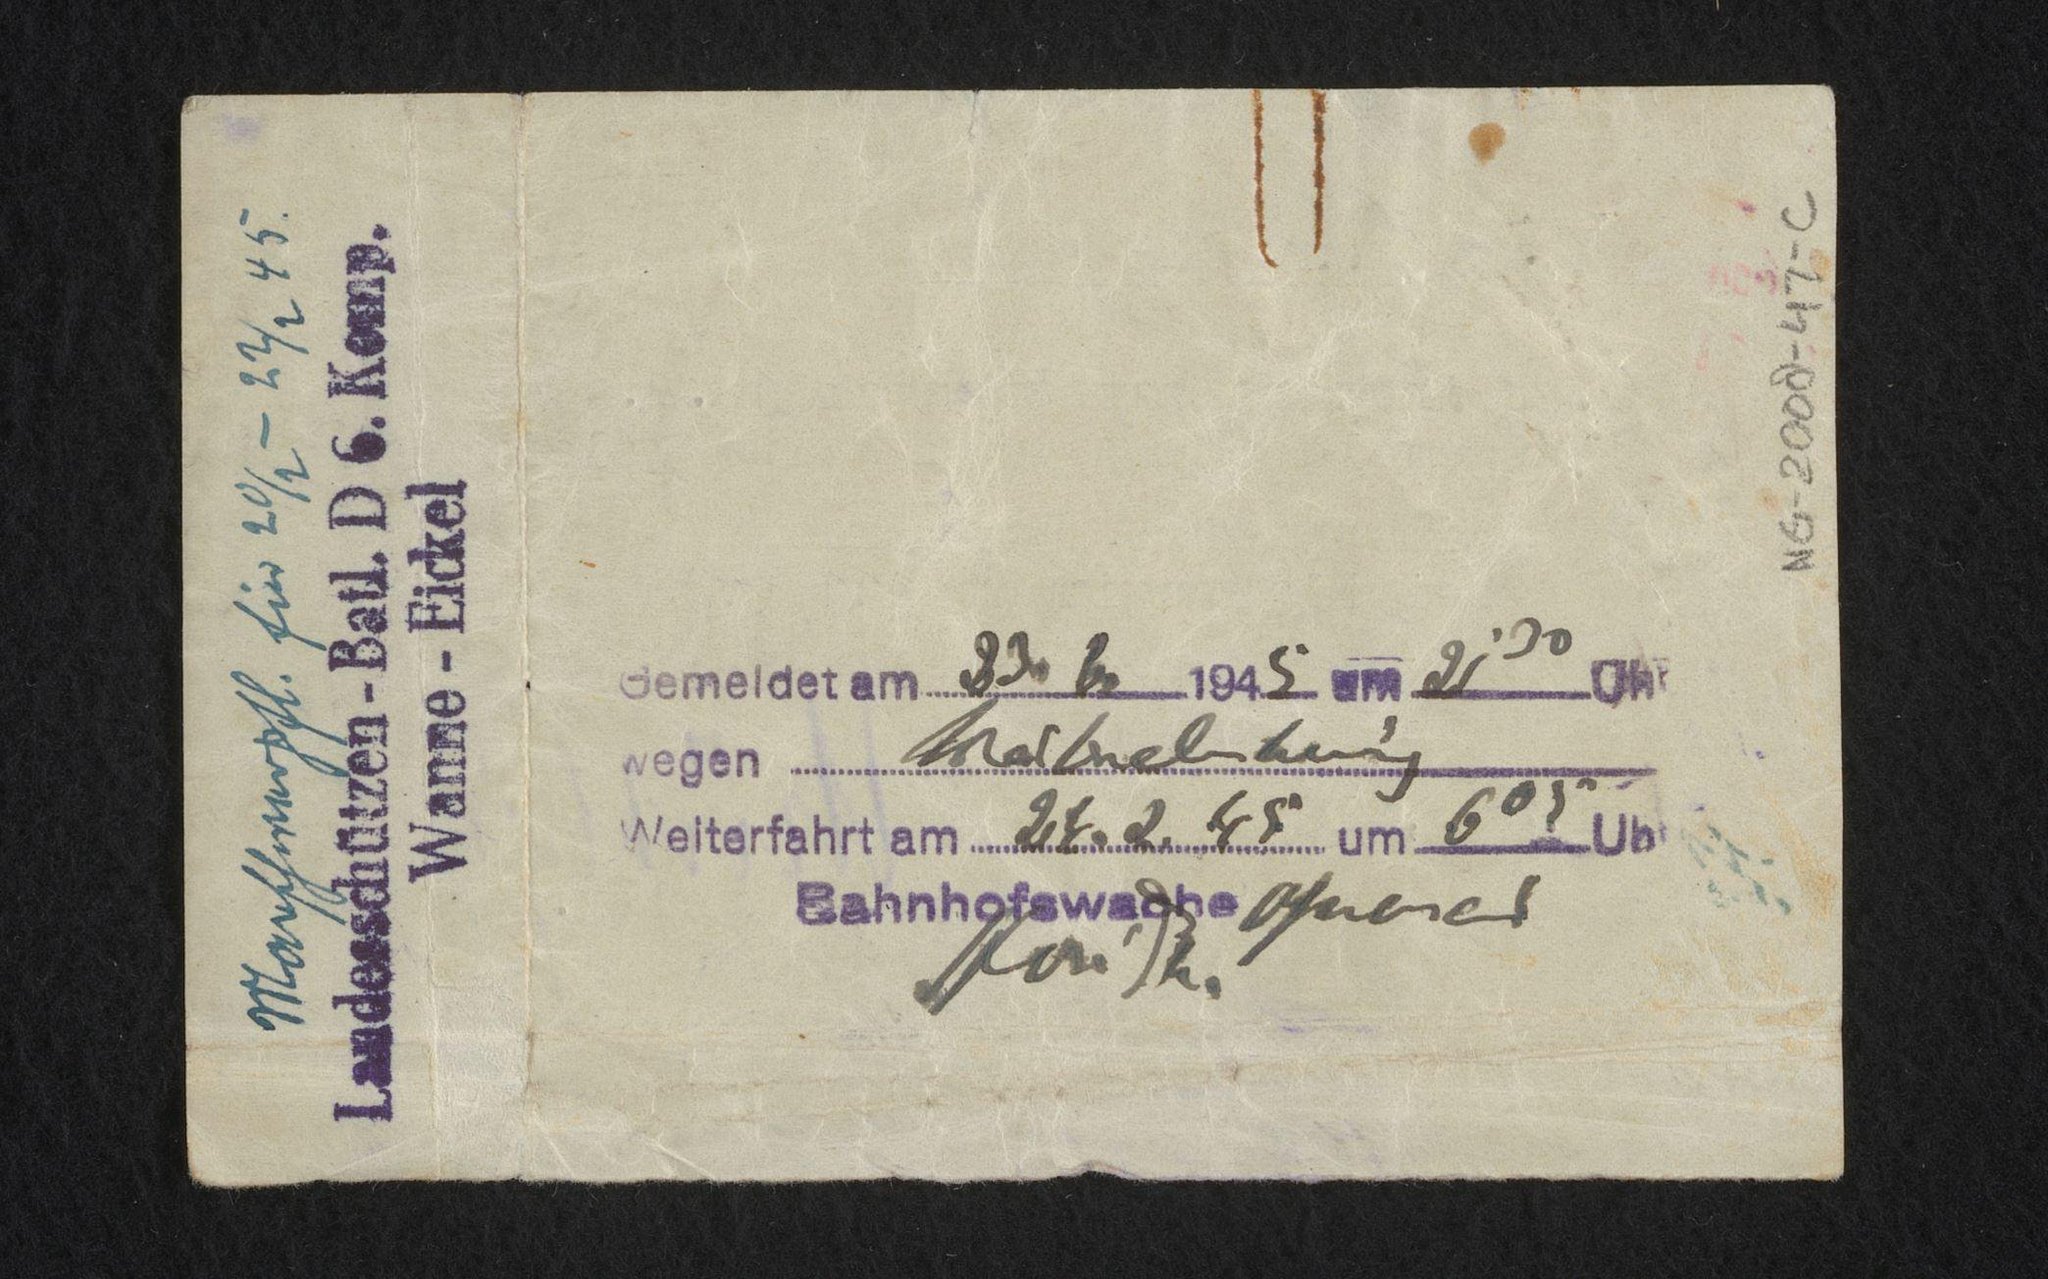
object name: document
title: Reisdocument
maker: Anonymous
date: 1945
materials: paper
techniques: printing, typewriting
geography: germany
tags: communication and transport, the soldier; the soldier's life, netherlands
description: Persoonlijke reisdocument van Hans Heineman, gedateerd 19 februari 1945. Document in melinexmapje los in de doos bij het fotoalbum 'Kriegszeit in Holland' over de diensttijd in Nederland van Hans Heinemann van een Flak Regiment van de Luftverteidigungskommando van de Luftwaffe.